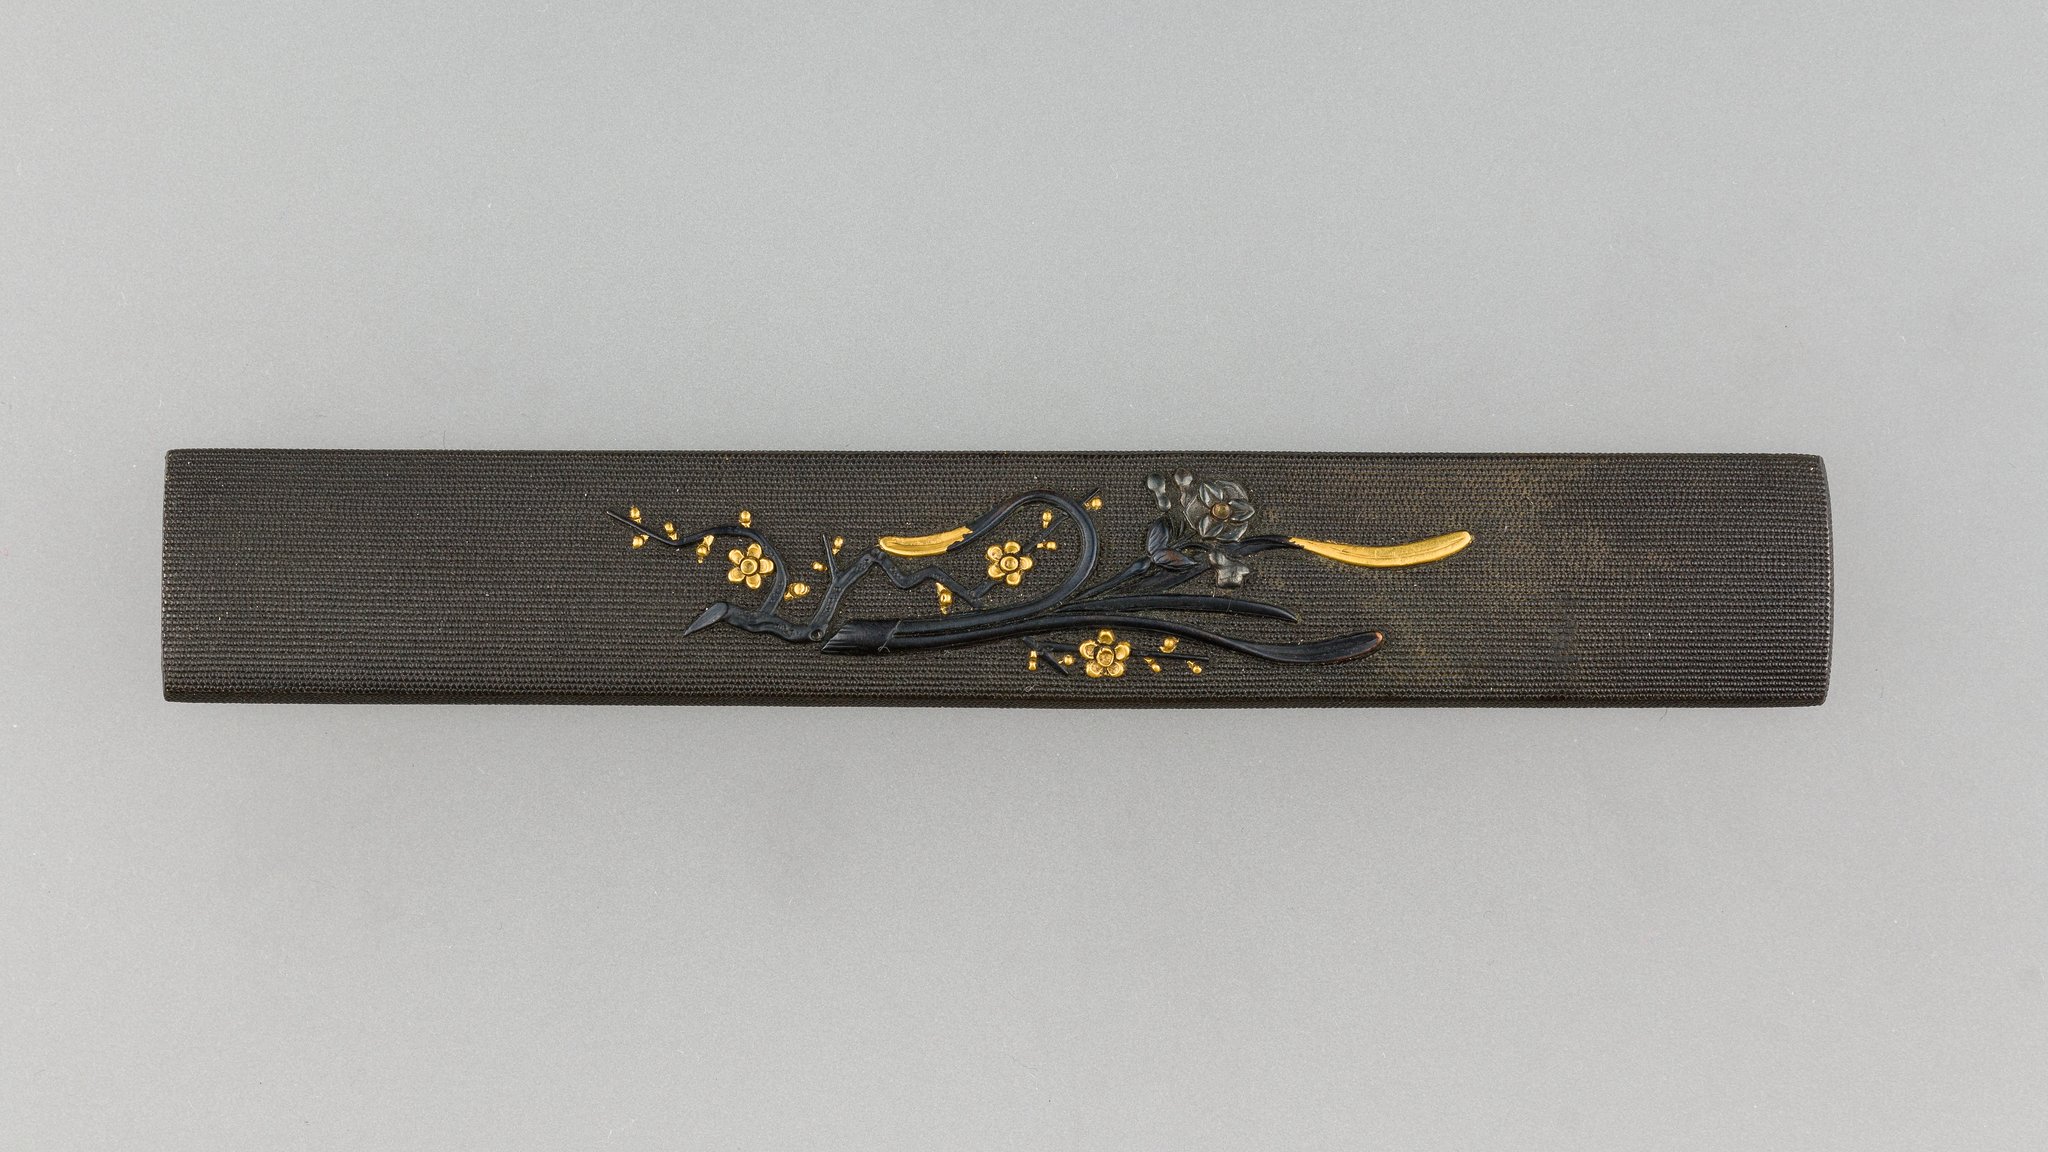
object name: knife handle kozuka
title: Knife Handle (Kozuka)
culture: japanese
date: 1701-1800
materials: gold alloy, gold, silver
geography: japan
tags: flowers